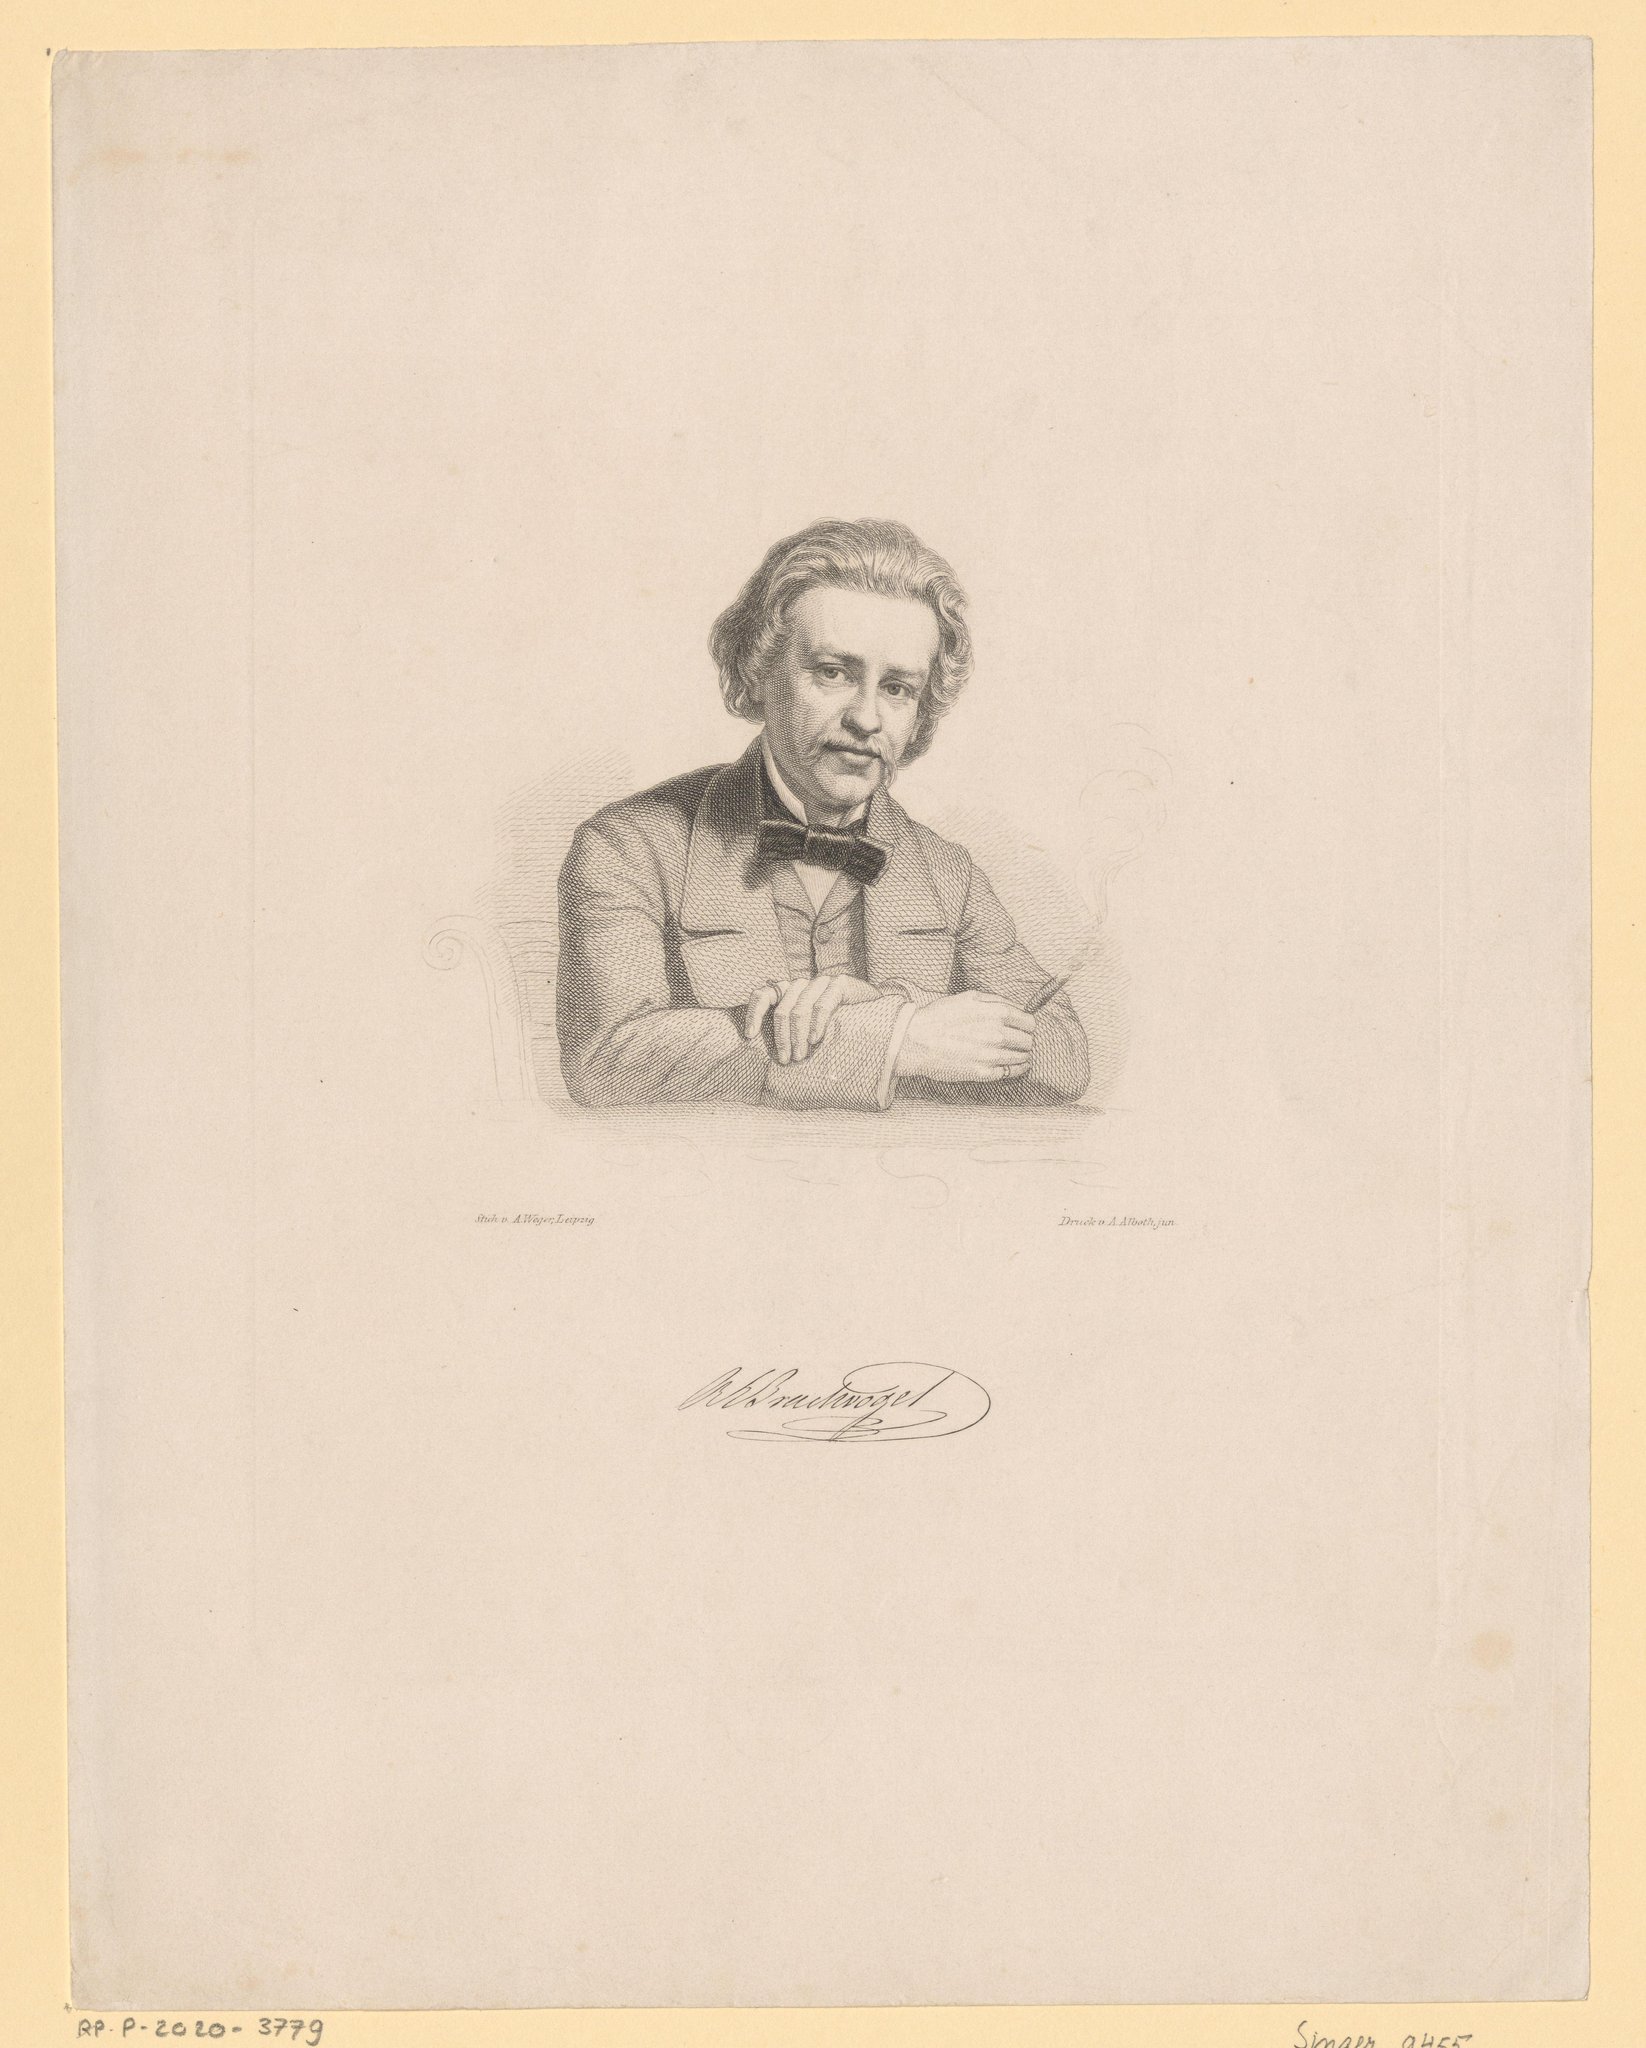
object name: print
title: Portret van Albert Emil Brachvogel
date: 1834-1888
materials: paper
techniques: engraving, etching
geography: leipzig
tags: berlin, historical persons, portrait of a writer